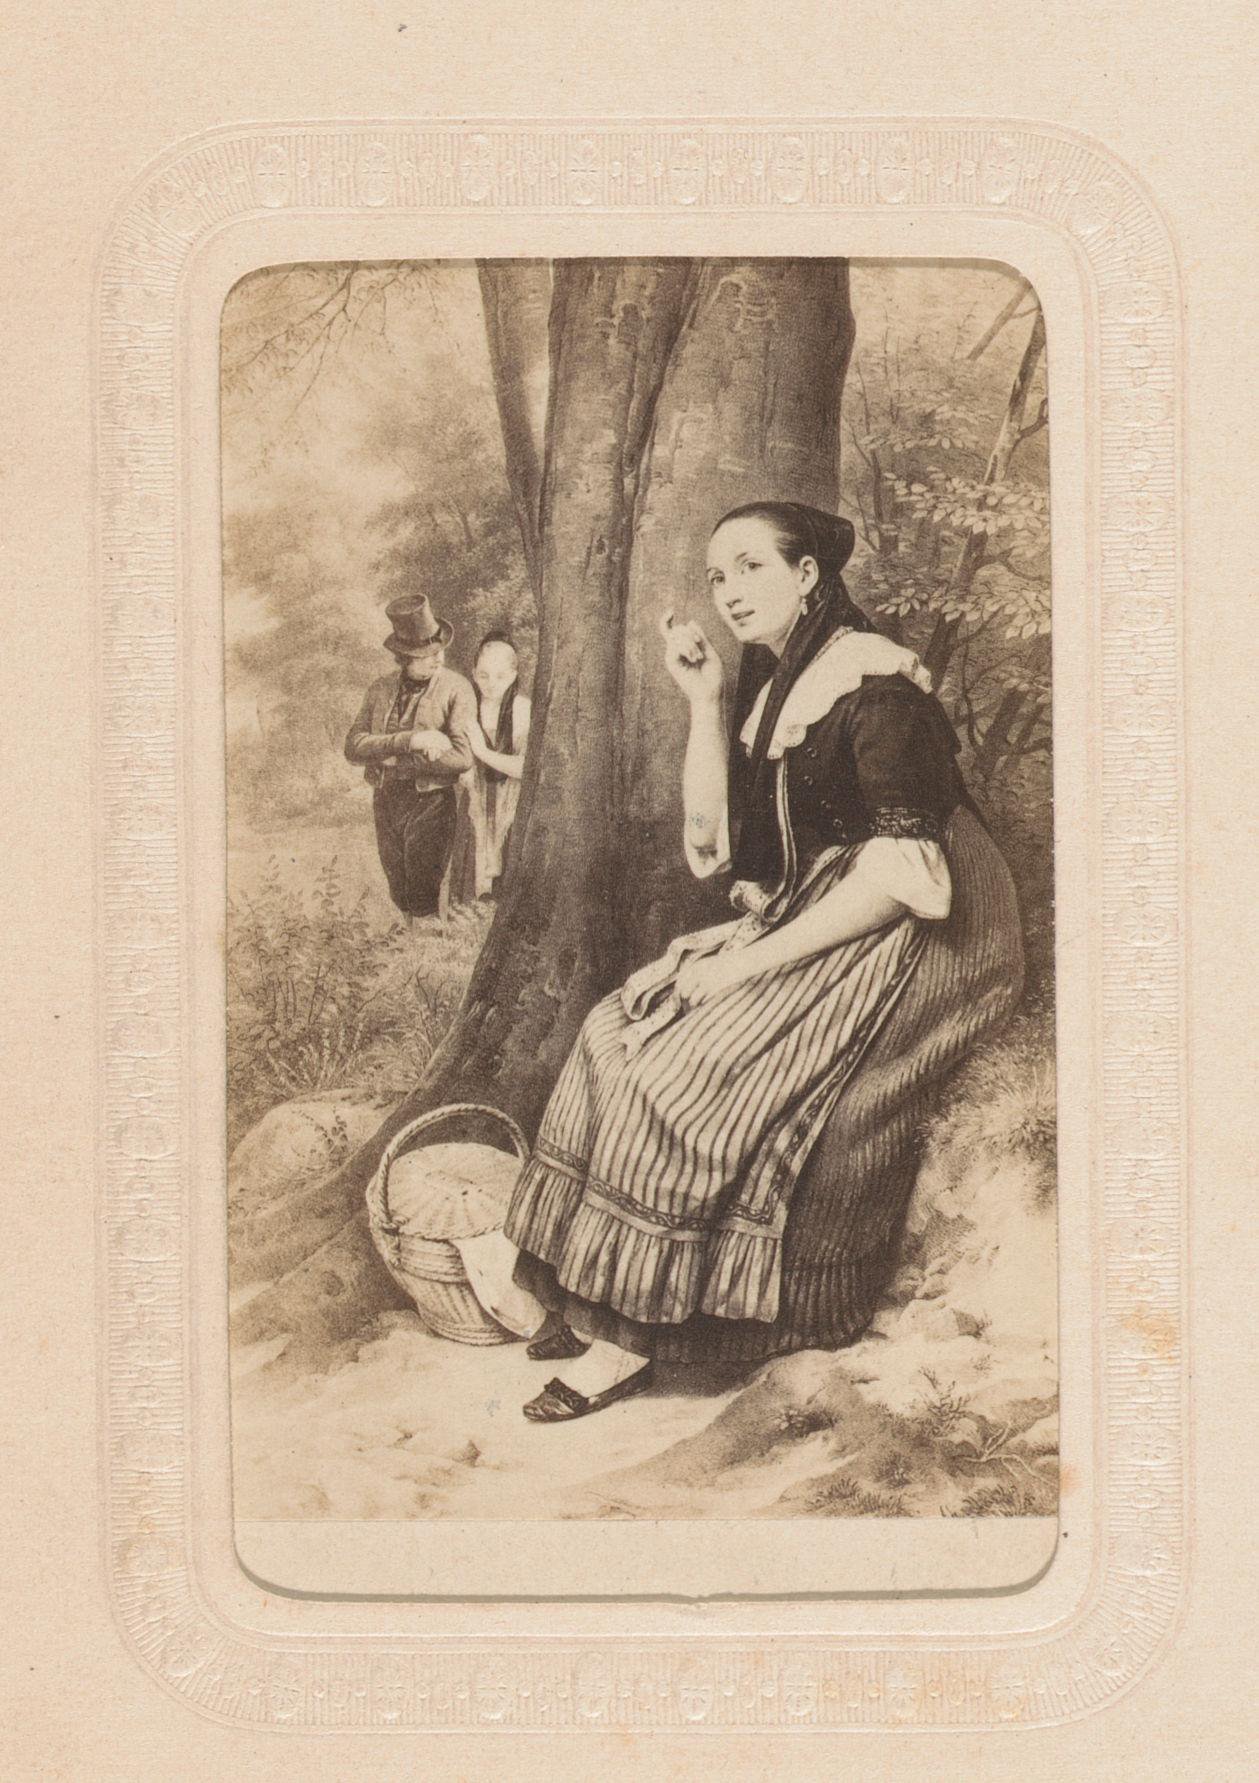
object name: photograph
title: Fotoreproductie van een schilderij met op de voorgrond een zittende vrouw en op de achtergrond een wandelend stel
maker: Anonymous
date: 1855-1865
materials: cardboard, photographic support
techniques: albumen print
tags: strolling, sitting on an elevation - aa - female human figure